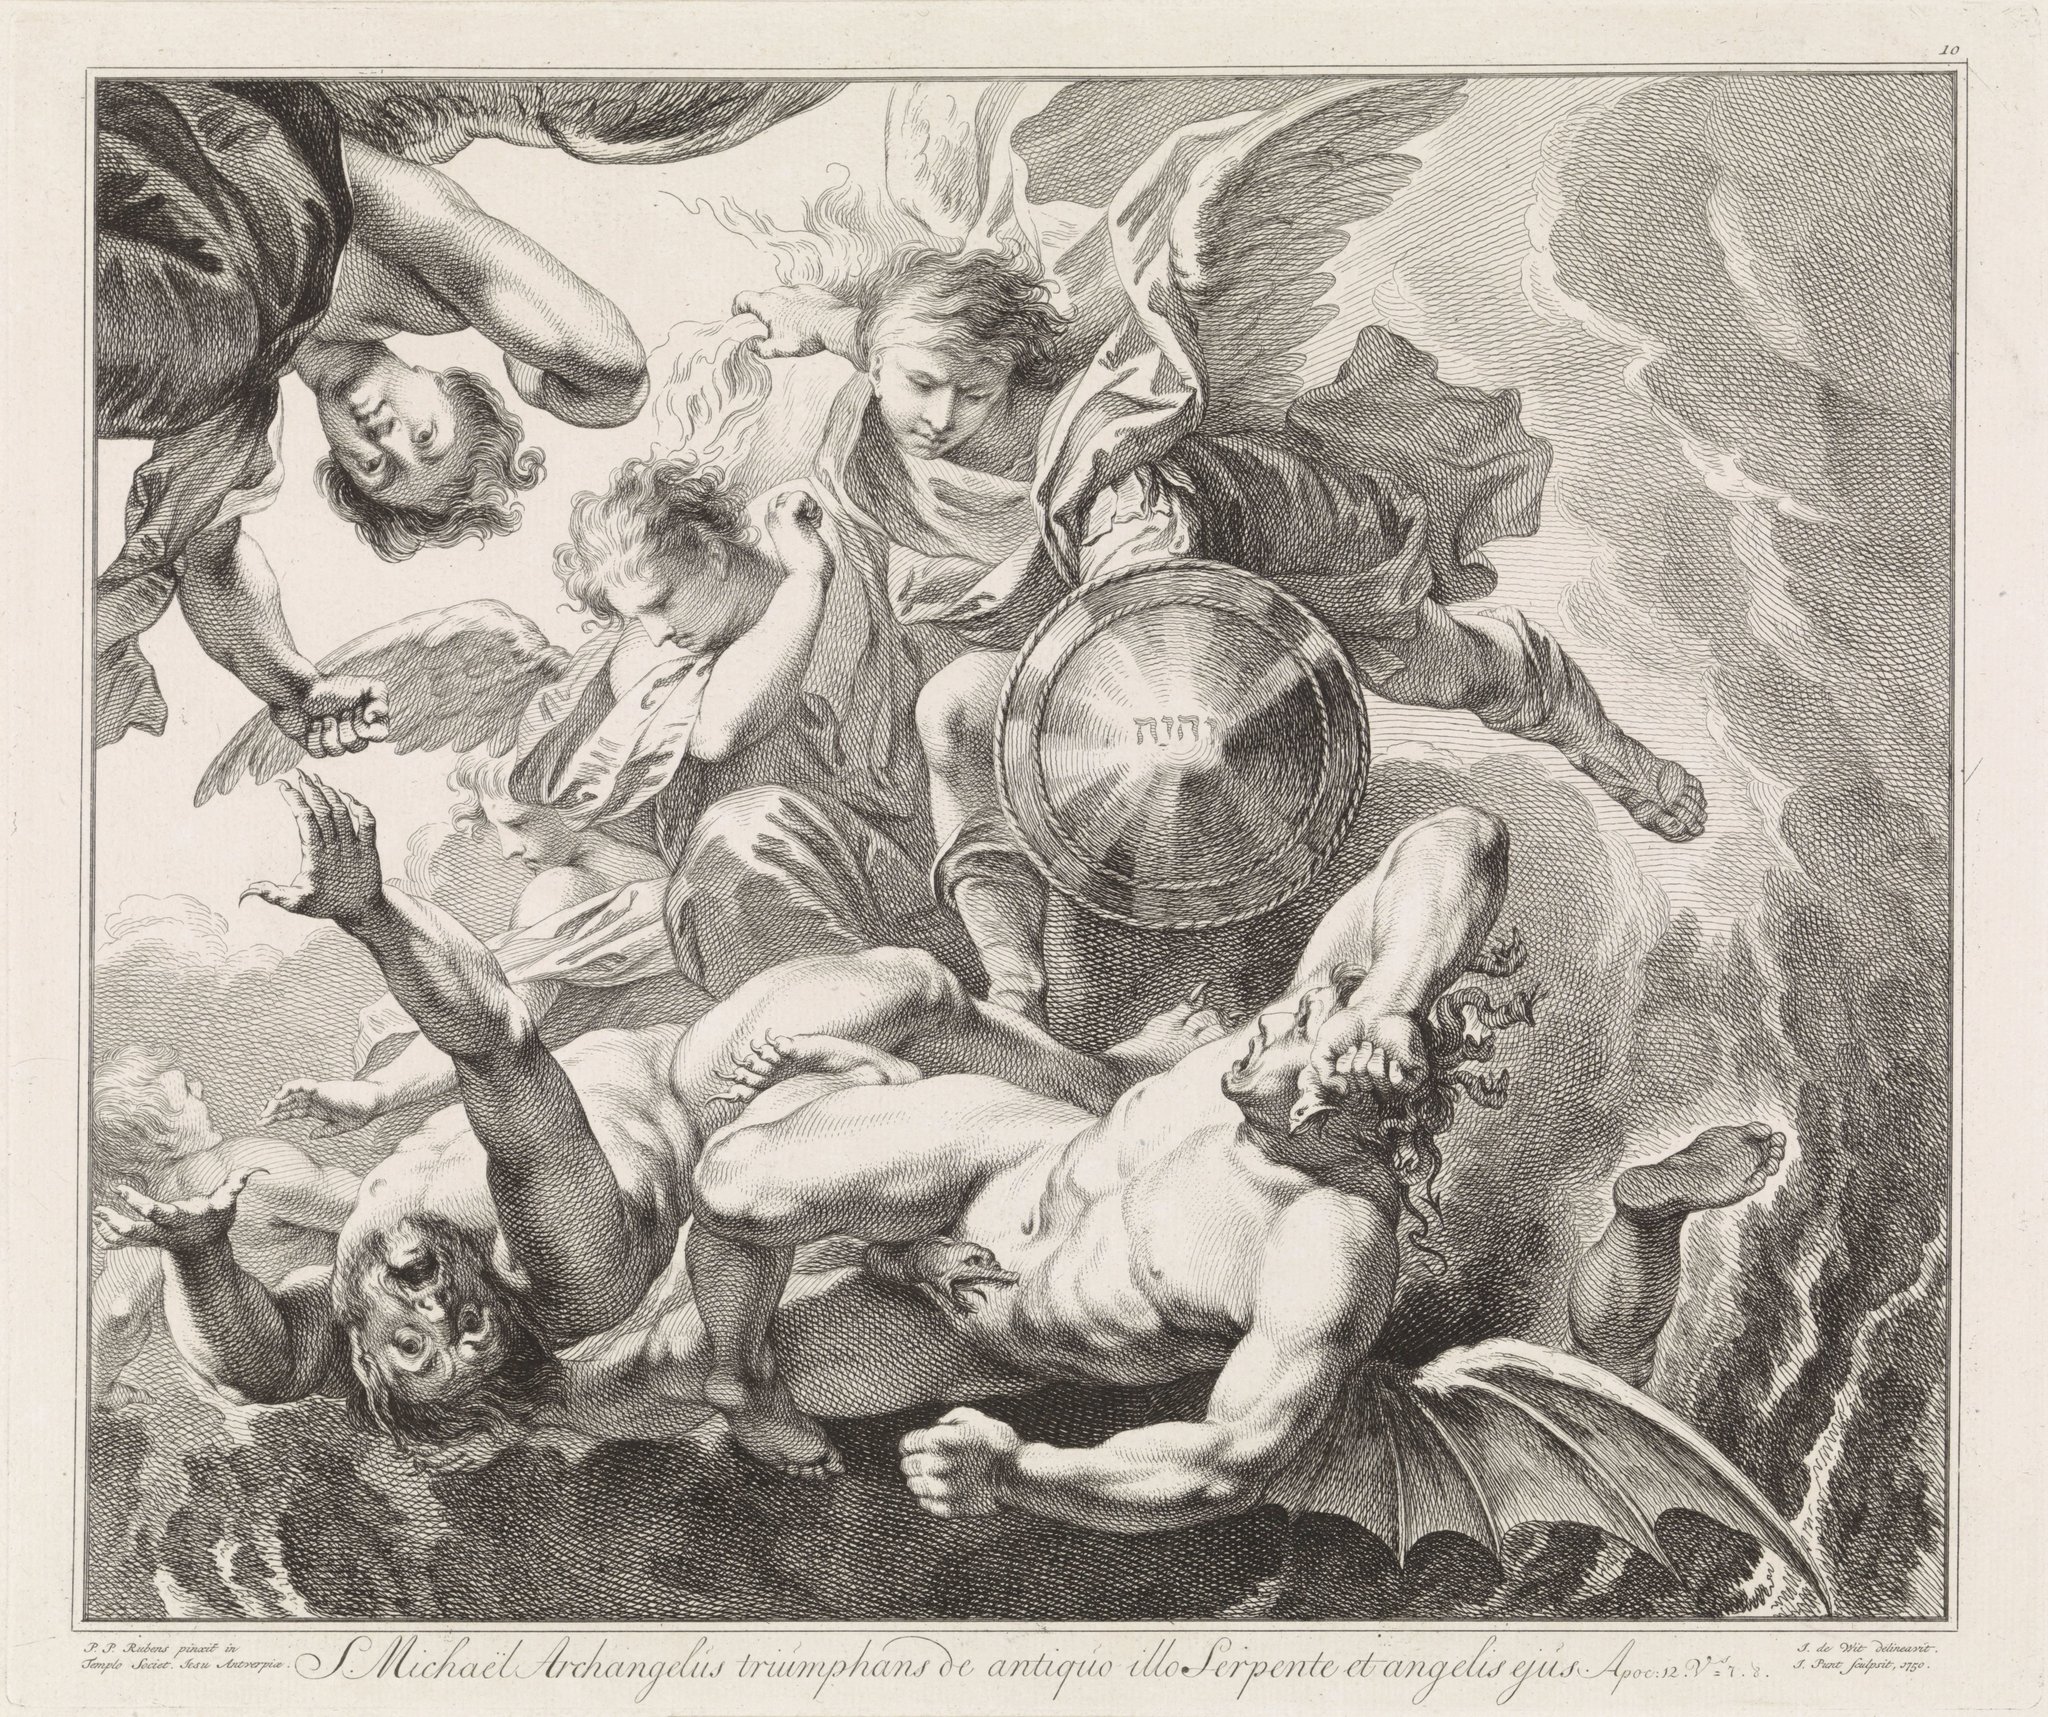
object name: print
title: Les plat-fonds ou les tableaux des galeries / De plafonds of gallerystukken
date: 1750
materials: paper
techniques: engraving, etching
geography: amsterdam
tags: michael and his angels fighting against the dragon and his followers; the dragon (devil, satan) is cast out of heaven (+ devil(s))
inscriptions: date: ‘1750’, collector's mark: Lugt 240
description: Met een drietal engelen vecht Michaël tegen duivels in menselijke gedaante. Onder de rechthoekige voorstelling een vers in het Latijn uit Op. 12:7-8.